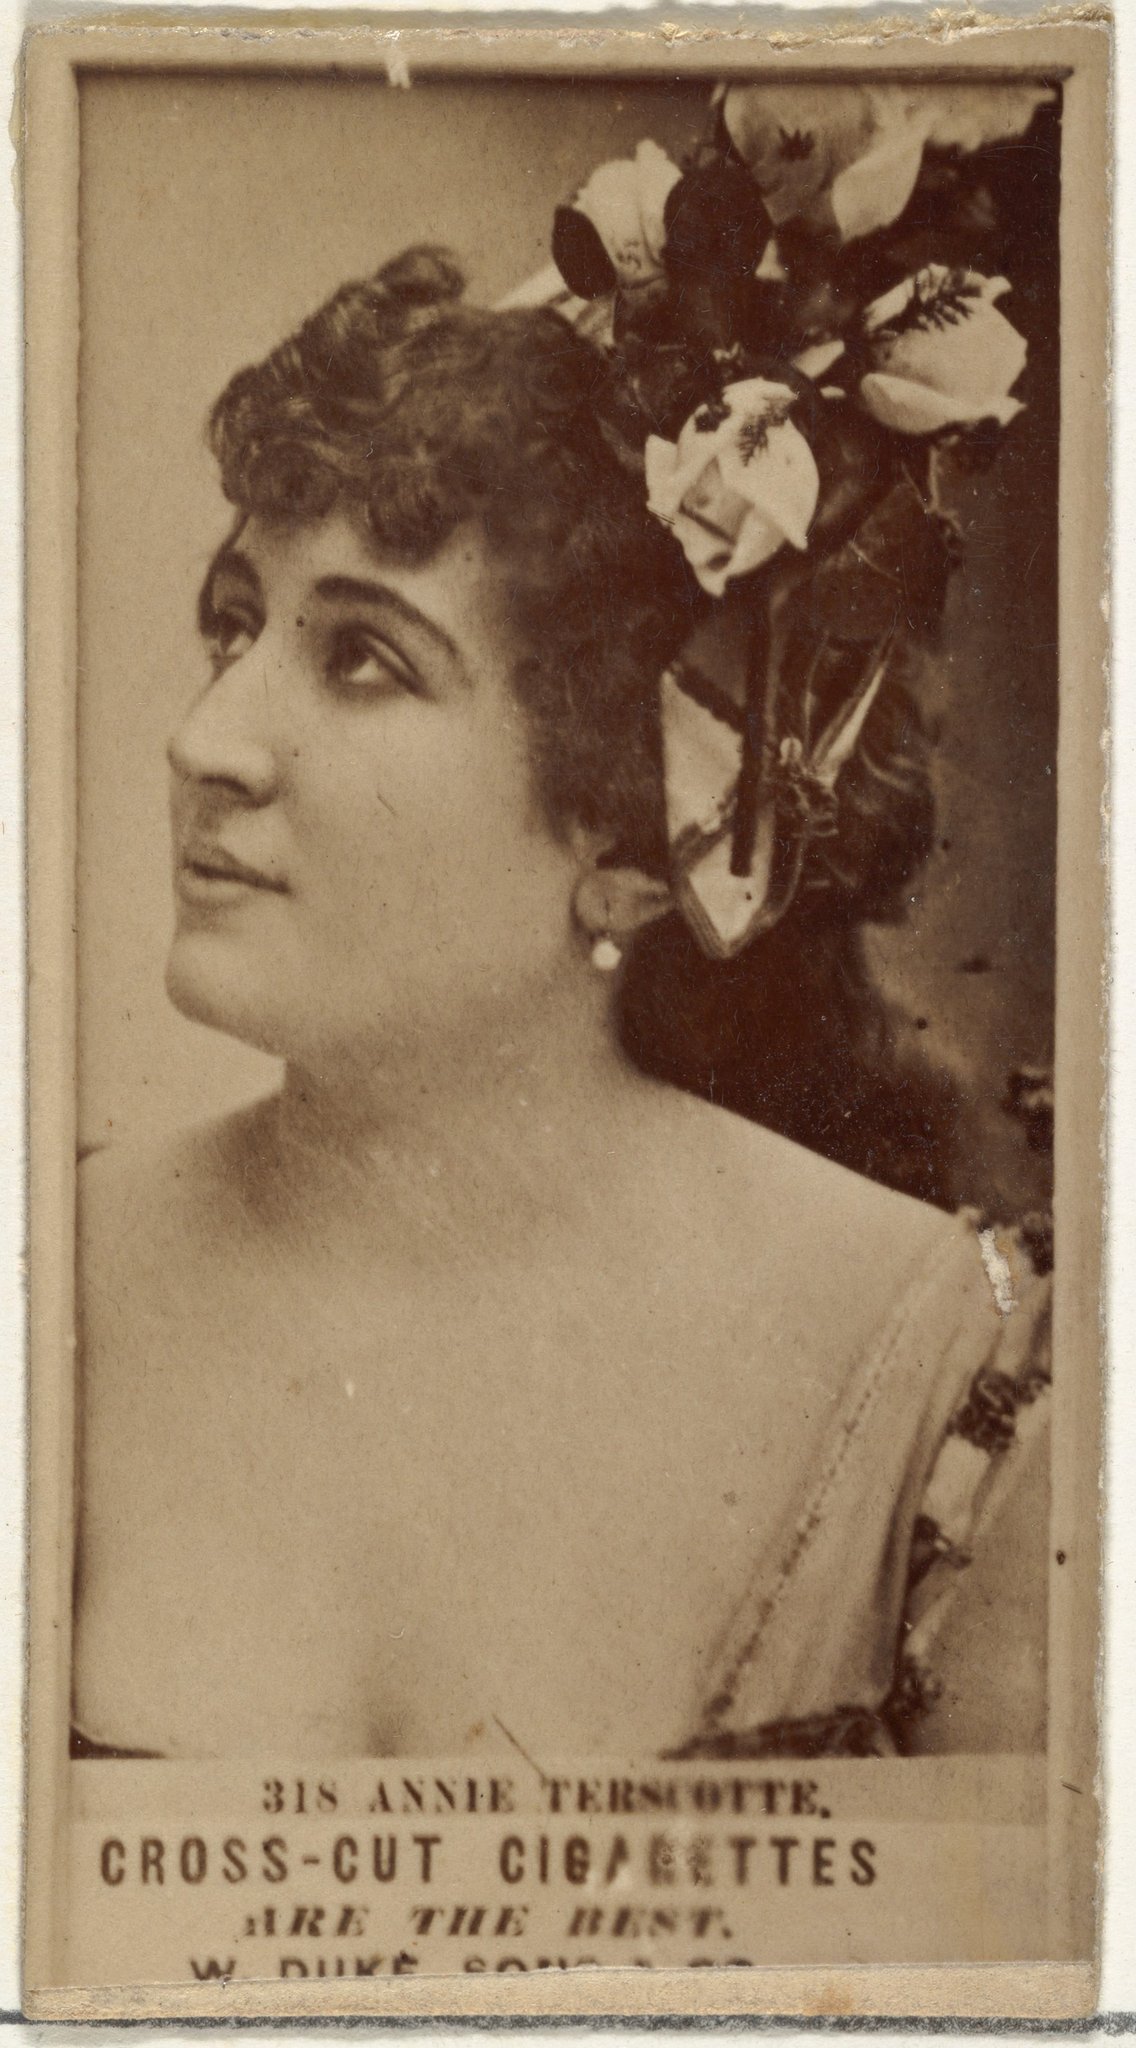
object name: photograph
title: Card Number 318, Annie Terscotte, from the Actors and Actresses series (N145-3) issued by Duke Sons & Co. to promote Cross Cut Cigarettes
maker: w. duke, sons & co.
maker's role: publisher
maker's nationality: american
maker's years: 1870-1920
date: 1880-1889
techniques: albumen silver print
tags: portraits,women,actresses